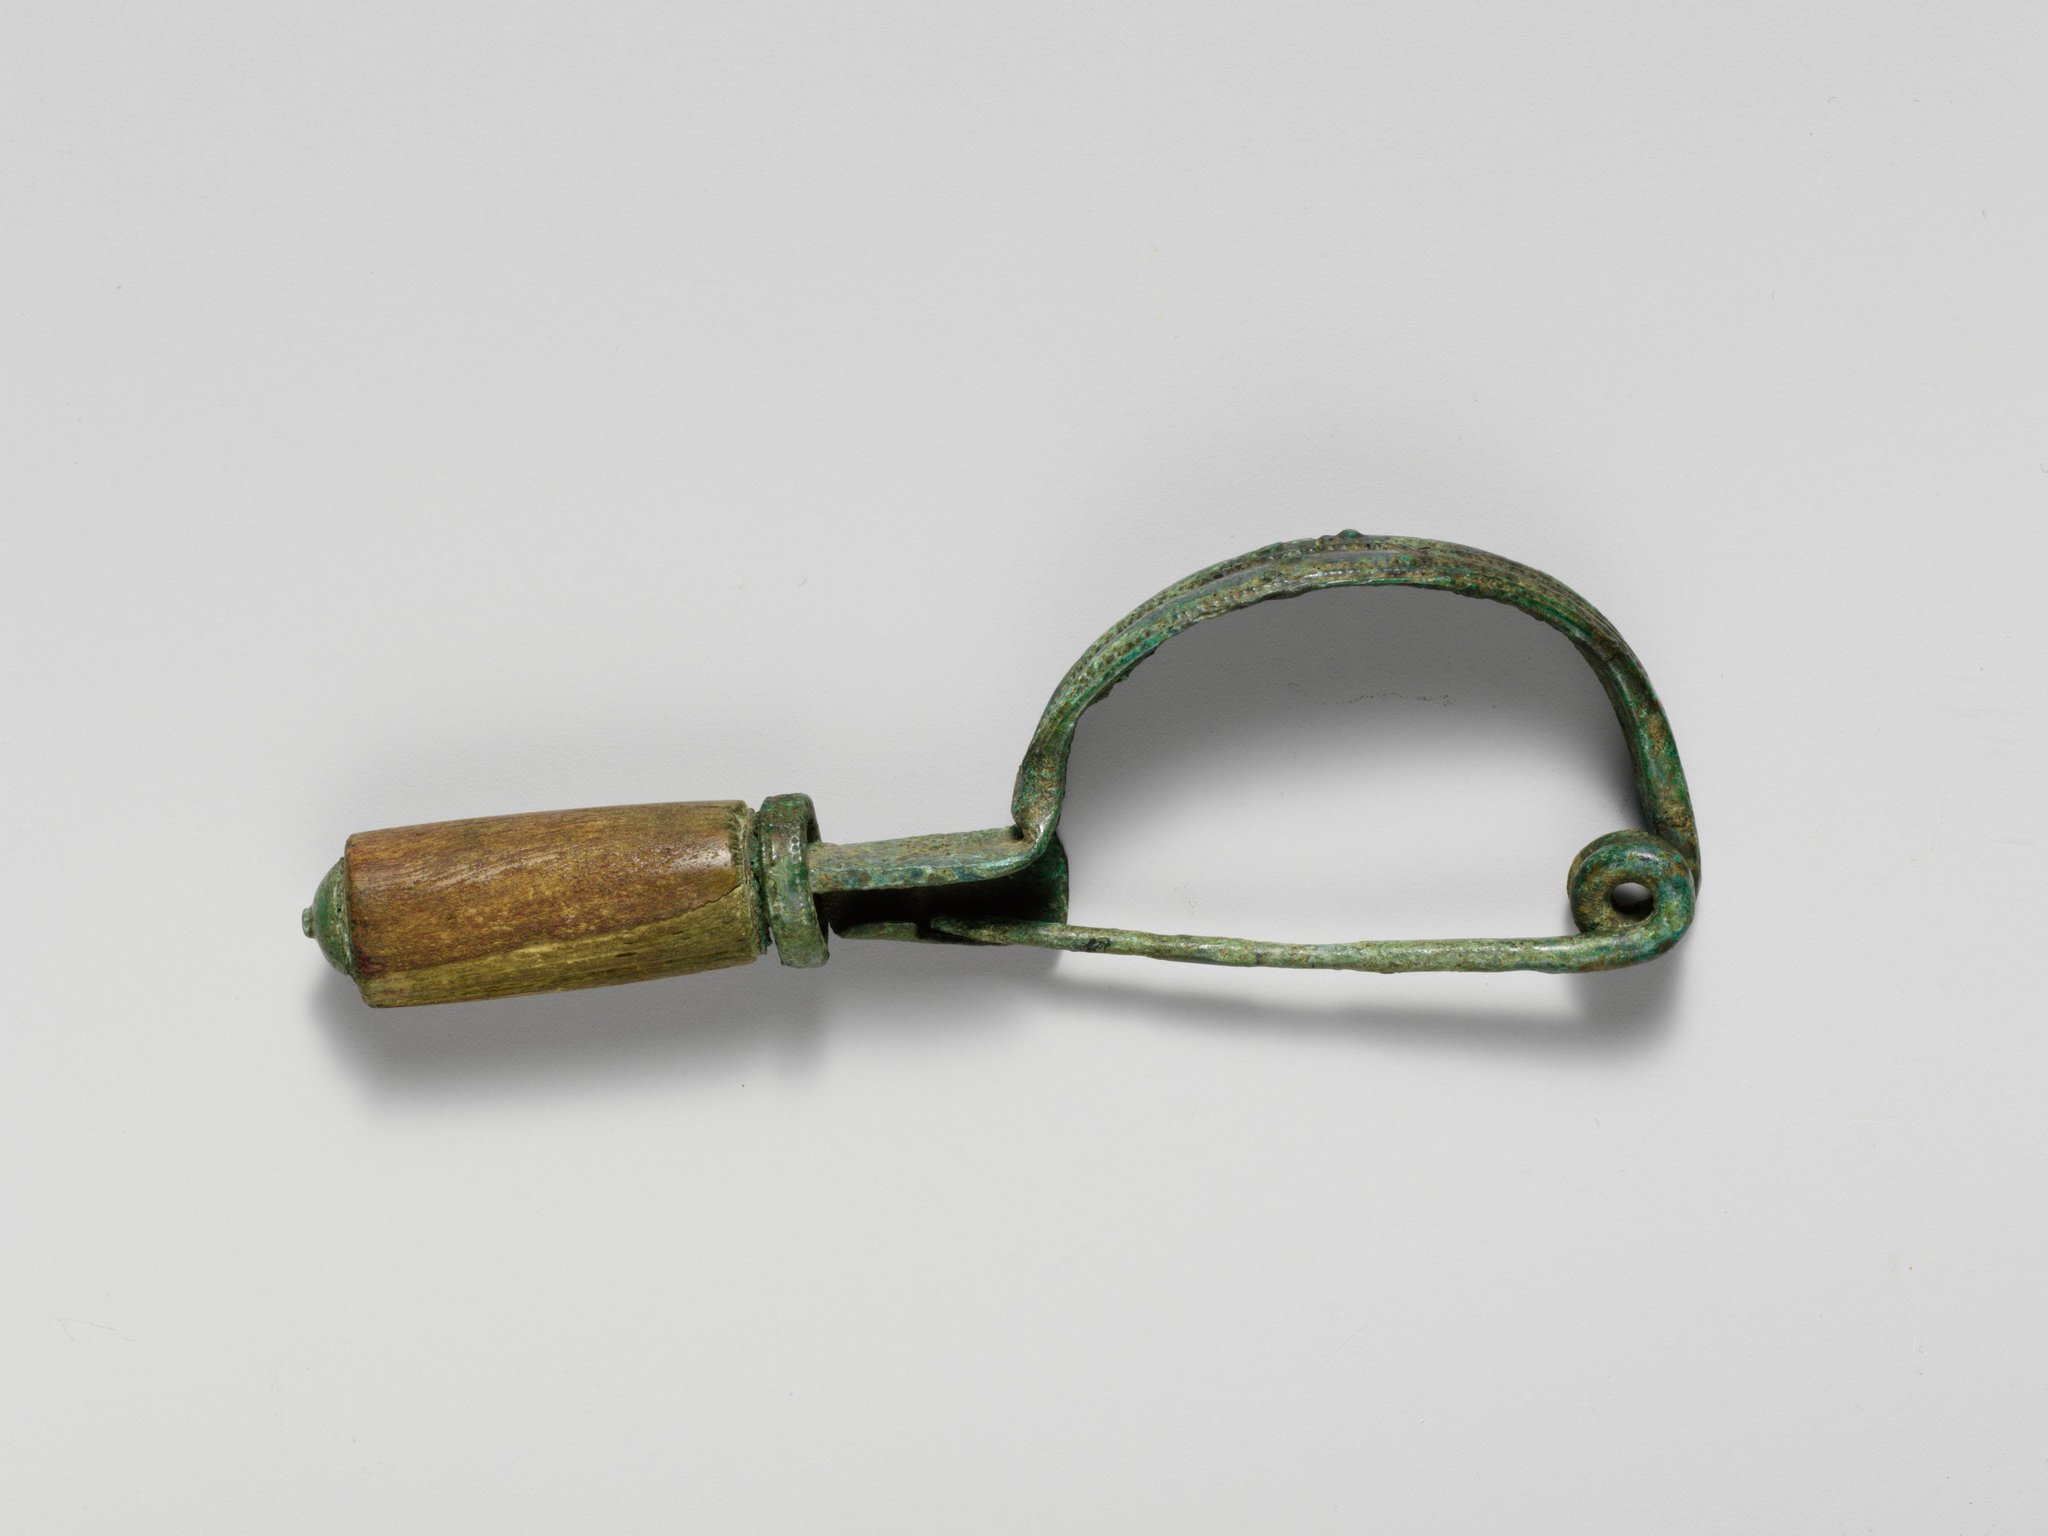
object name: fibula with bone cylinder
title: Bronze bow-shaped fibula (safety pin) with bone cylinder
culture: italic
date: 800-701 BCE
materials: bone, bronze